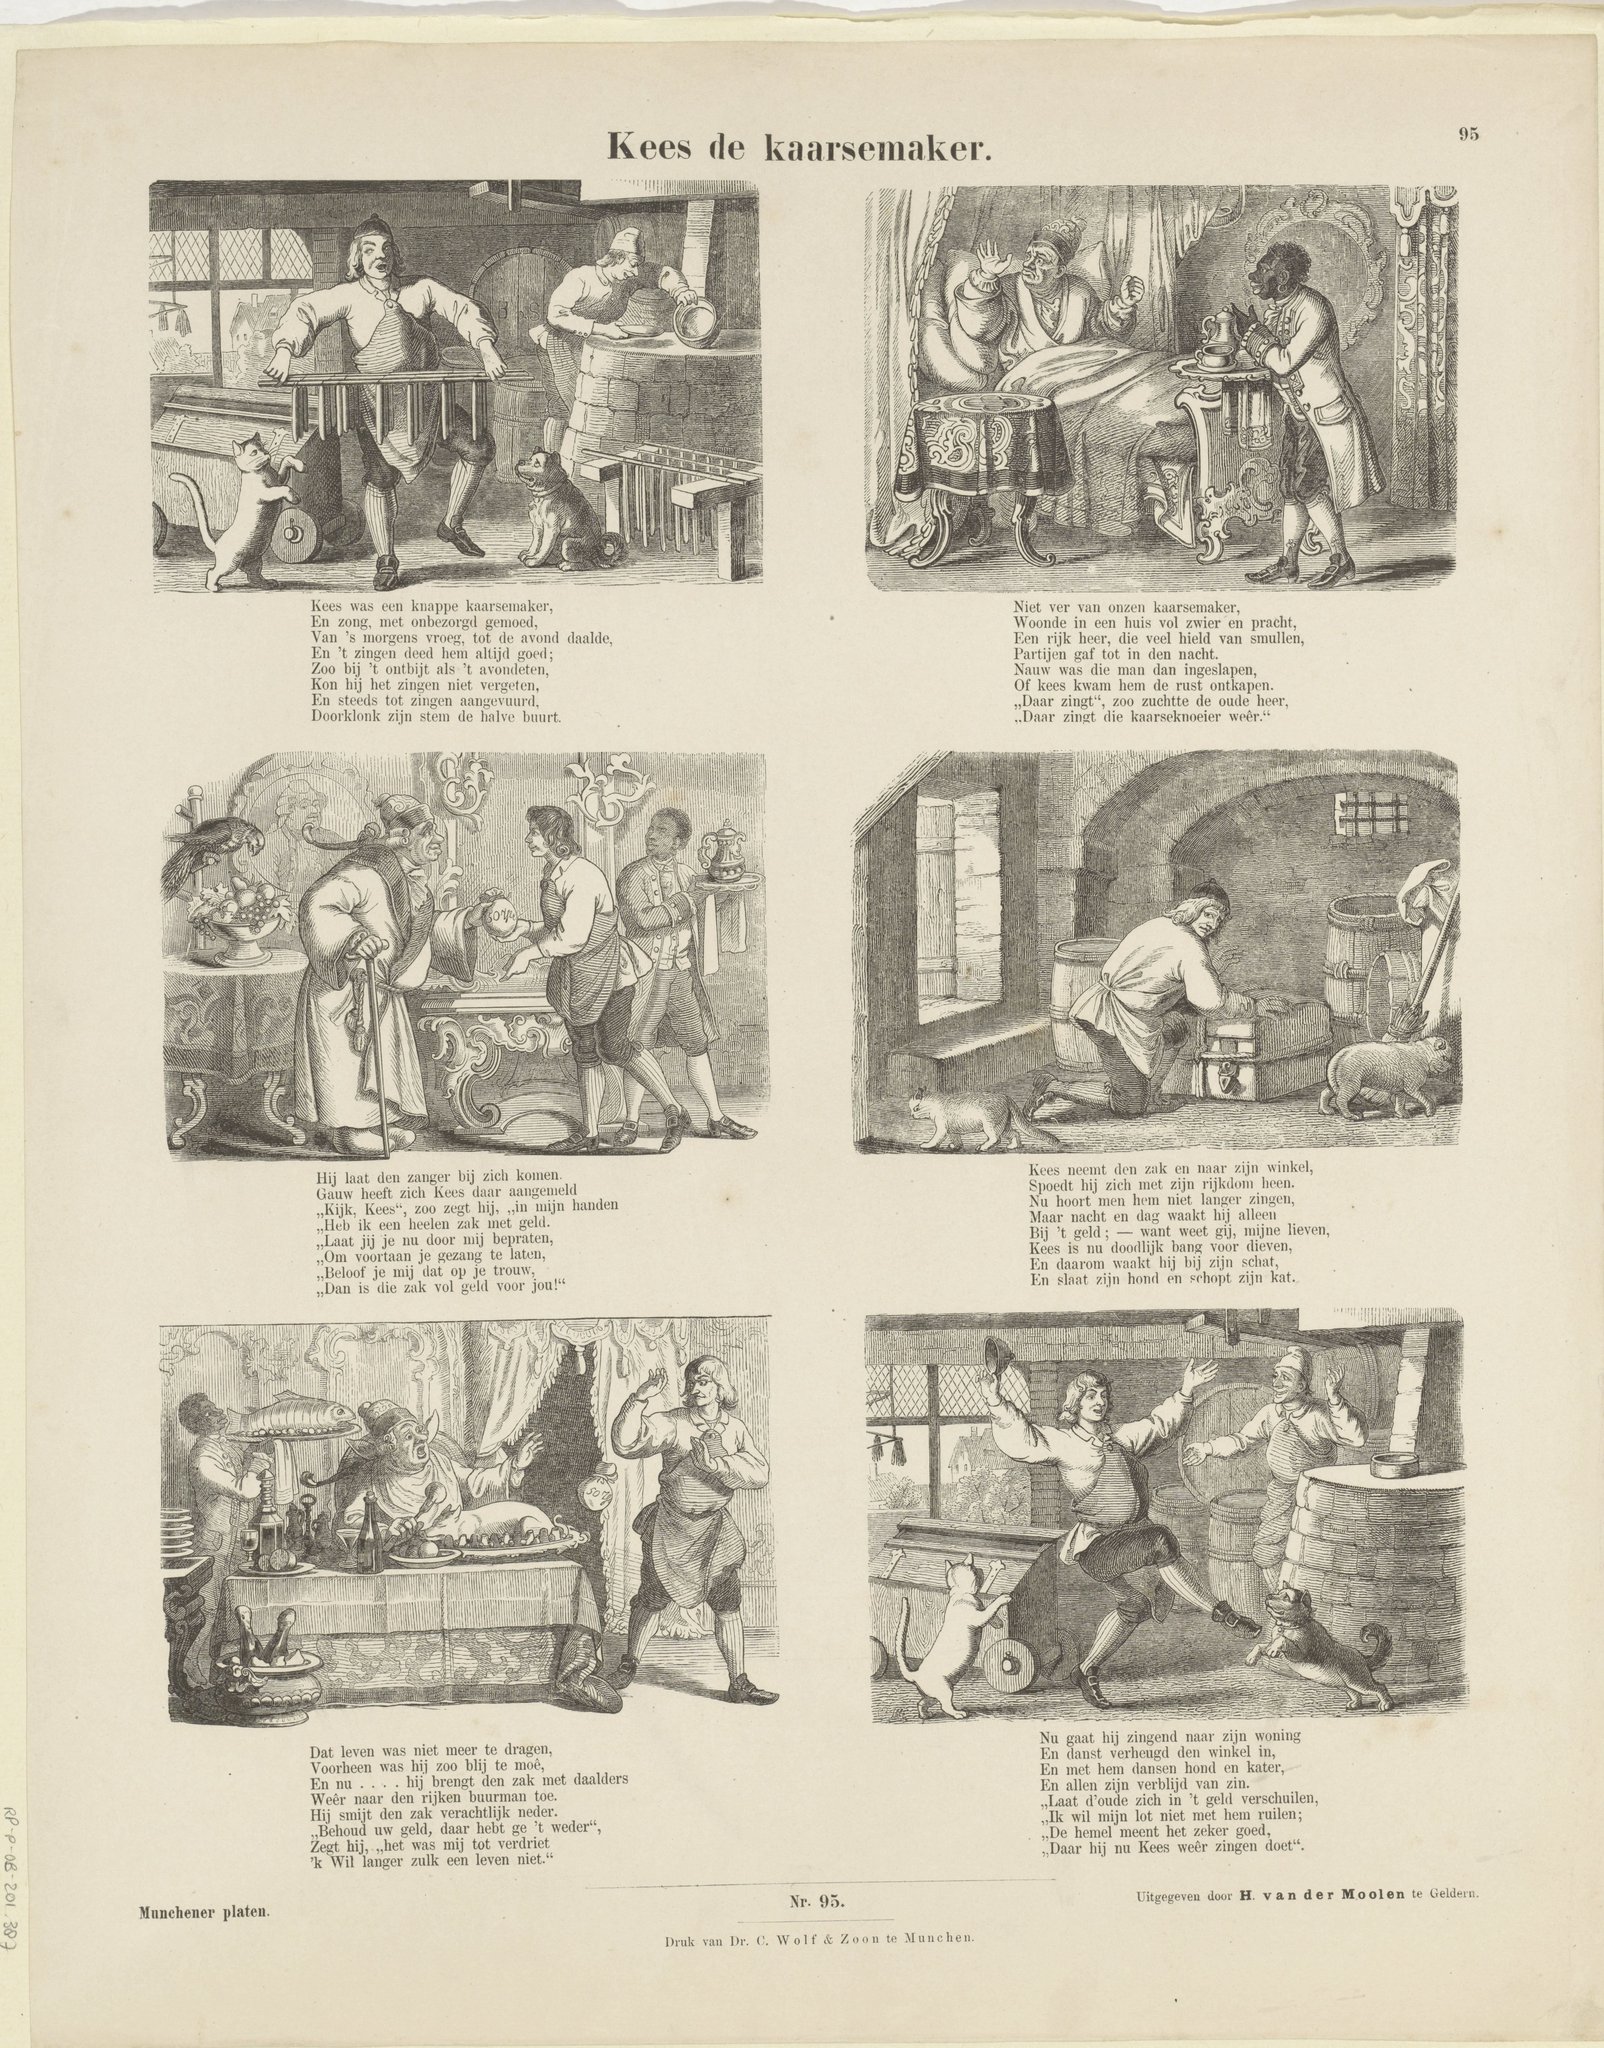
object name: print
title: Kees de kaarsemaker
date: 1820-1843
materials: paper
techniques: letterpress printing, engraving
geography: munich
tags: craft-production, skilled handiwork, vocal music, singing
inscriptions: collector's mark: Lugt 2760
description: Blad met 6 voorstellingen over Kees de zingende kaarsenmaker die zingen belangrijker vindt dan geld. Onder de afbeeldingen een achtregelig vers. Genummerd midden onder: Nro. 95. Genummerd rechtsboven: 95.